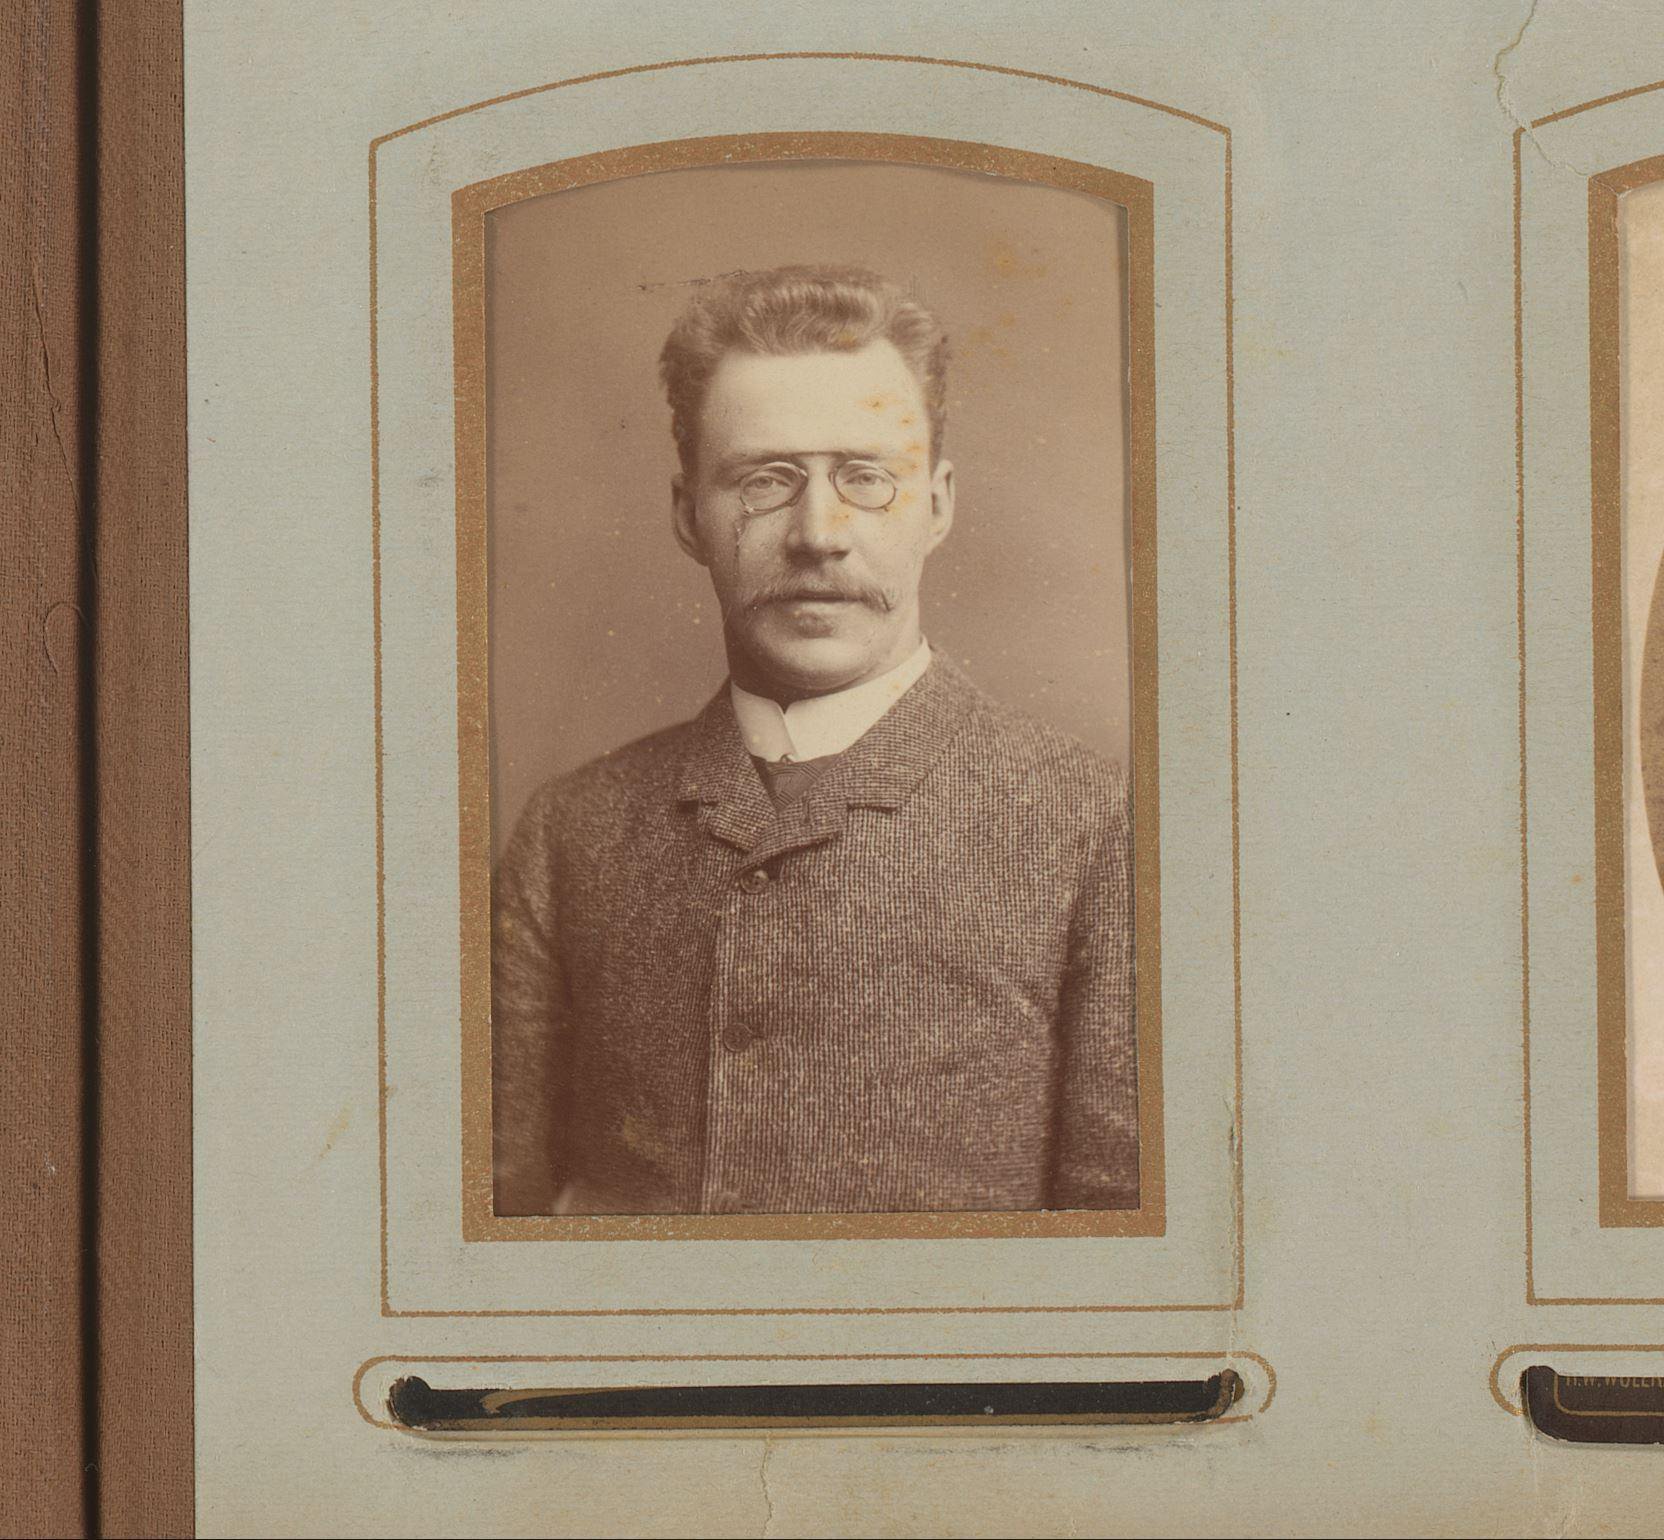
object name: carte de visite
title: Portret van een man met bril en snor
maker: franz wilhelm heinrich deutmann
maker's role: fotograaf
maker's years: 1840-1906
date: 1883-1905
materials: cardboard, photographic support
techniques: albumen print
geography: zwolle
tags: moustache, historical persons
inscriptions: inscription: ‘Amsterdam 1883/ F.W.H. Deutmann/ Zwolle/ Kamperstraat’